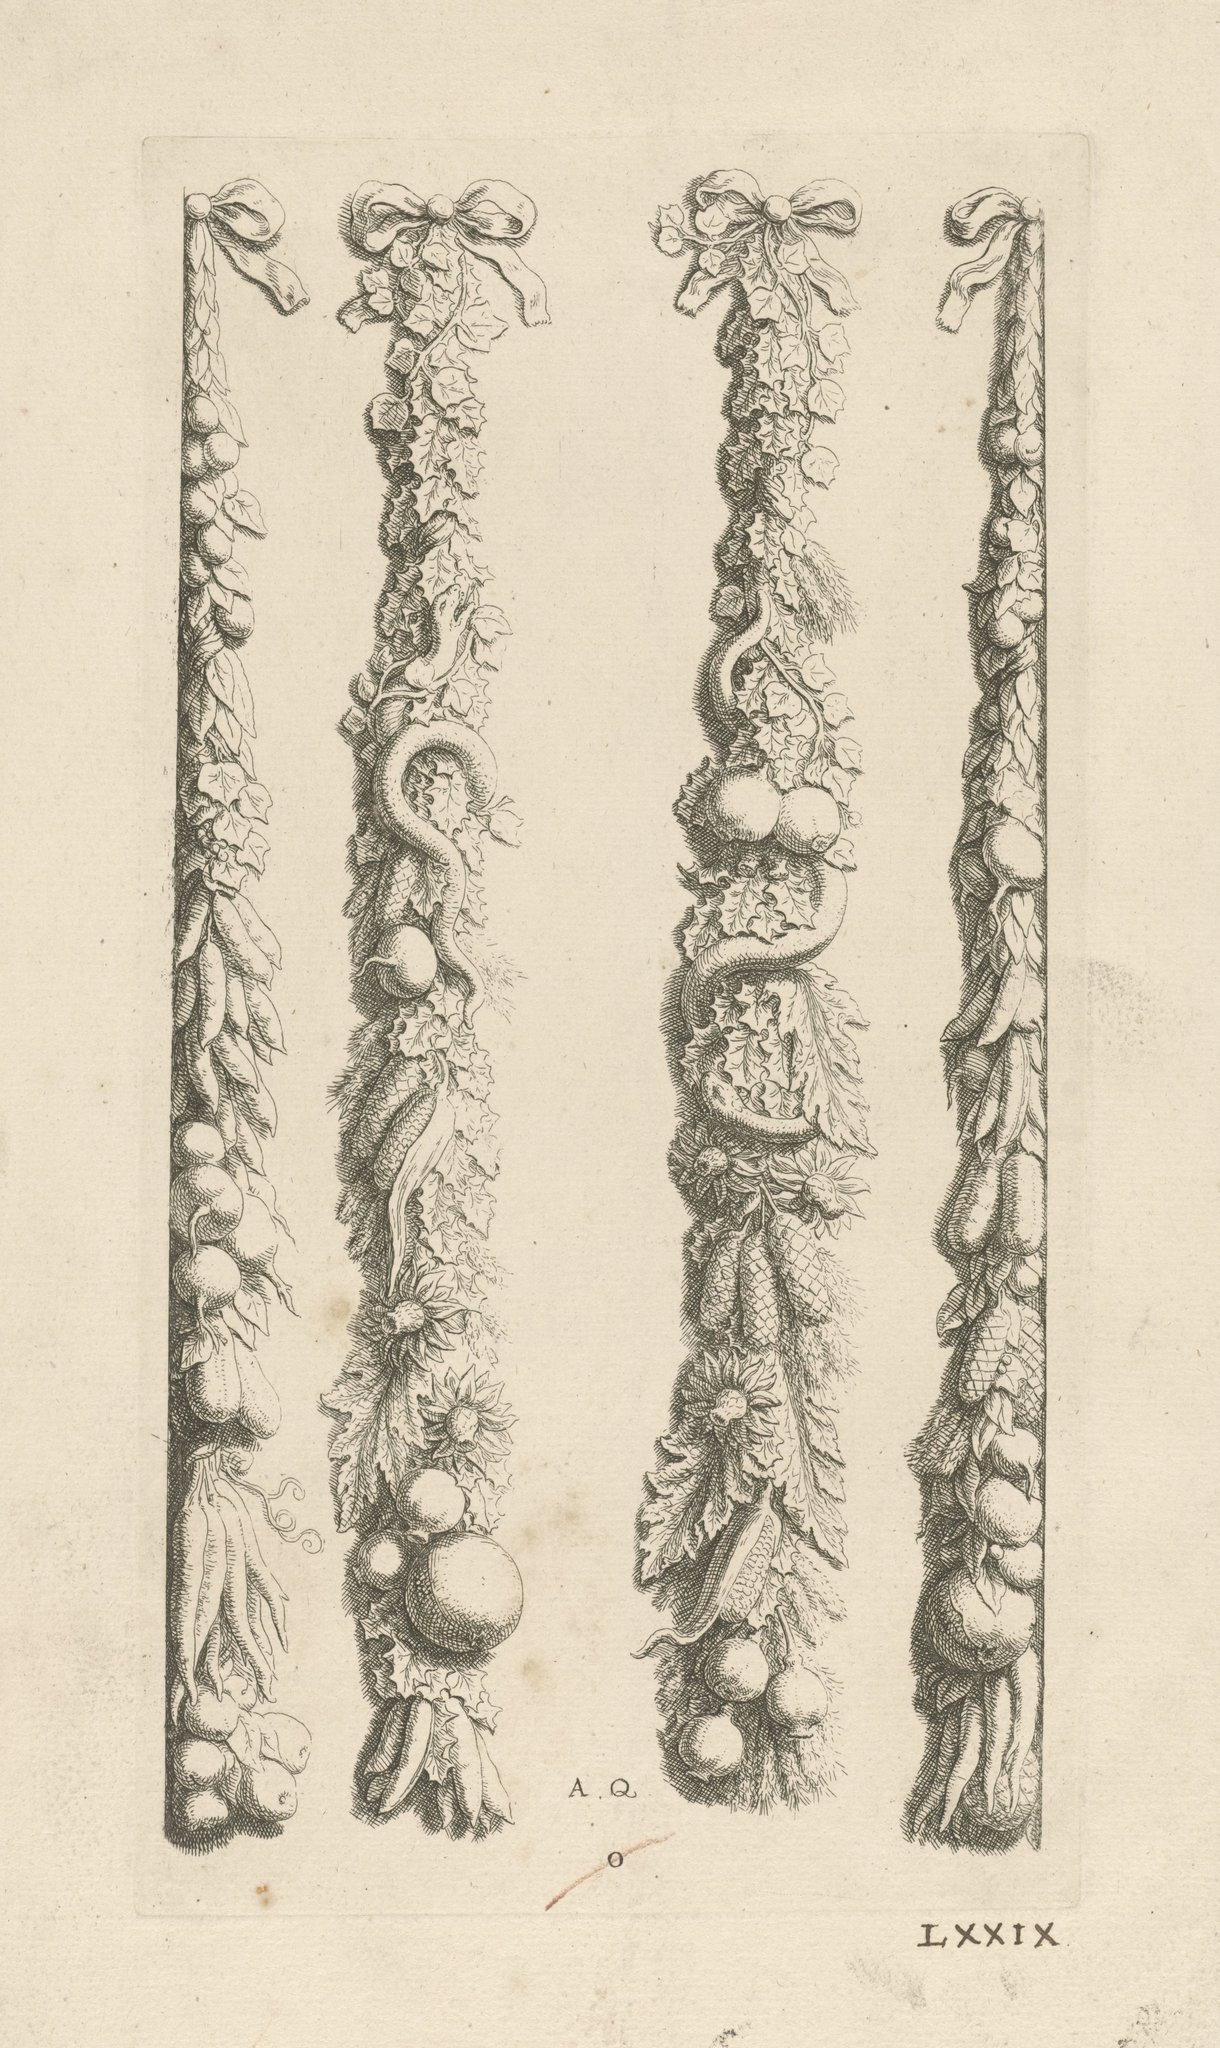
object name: ornament print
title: Prima Pars Praecipuarum (...)/ Het Eerste Deel Van de voornaemste Statuen ende Cieraten (...)/ La Premier Parti (...)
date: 1665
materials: paper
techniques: etching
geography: amsterdam